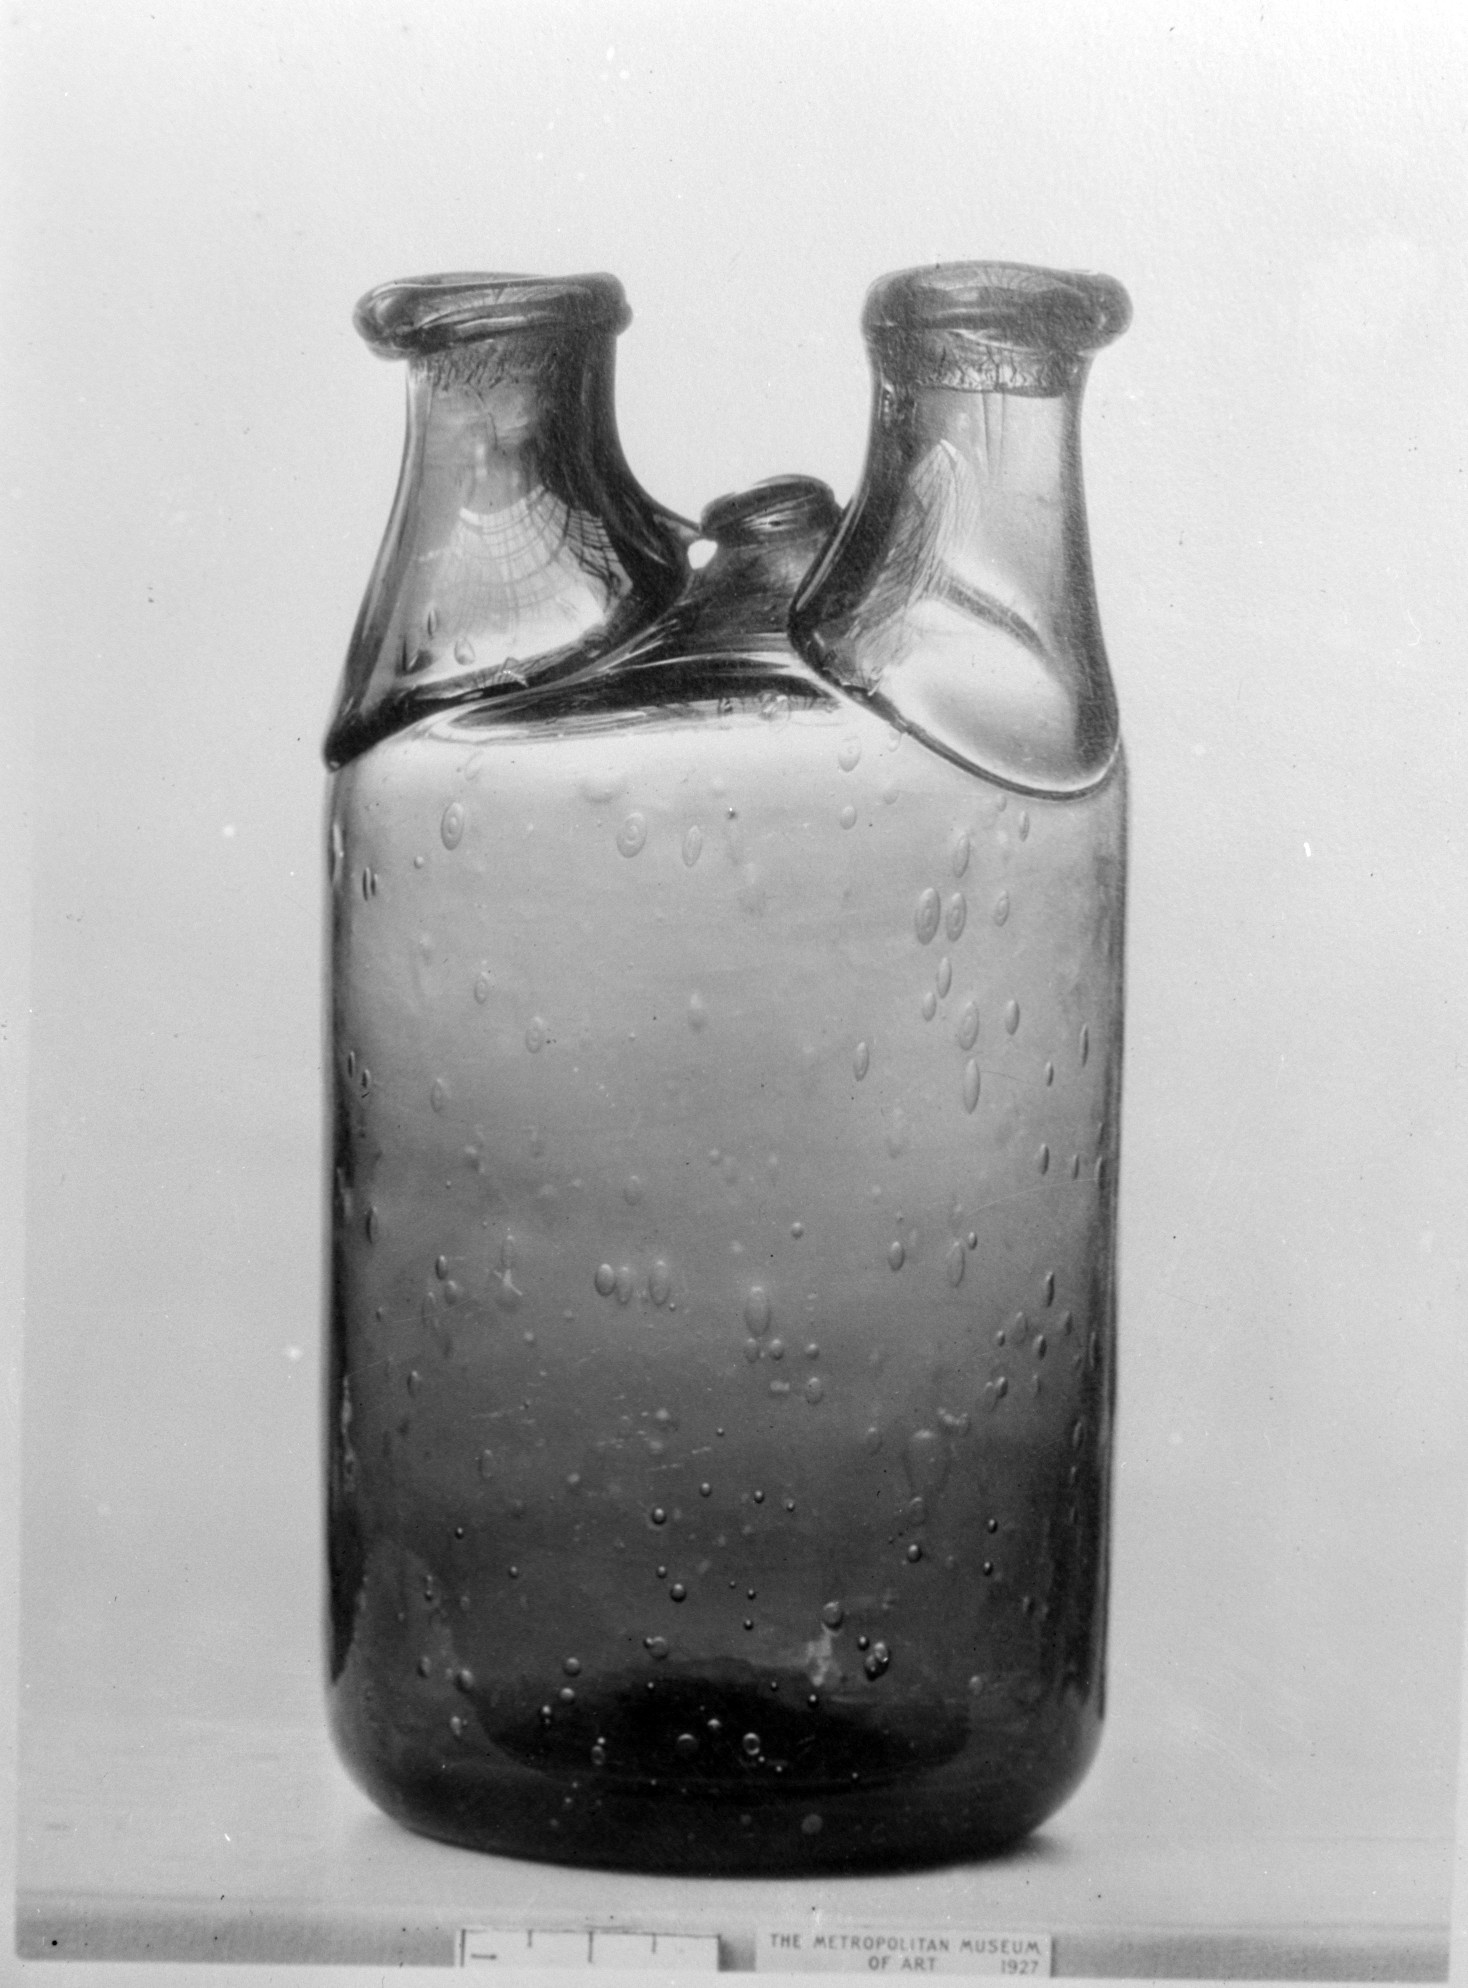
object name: bottle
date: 1601-1700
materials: glass